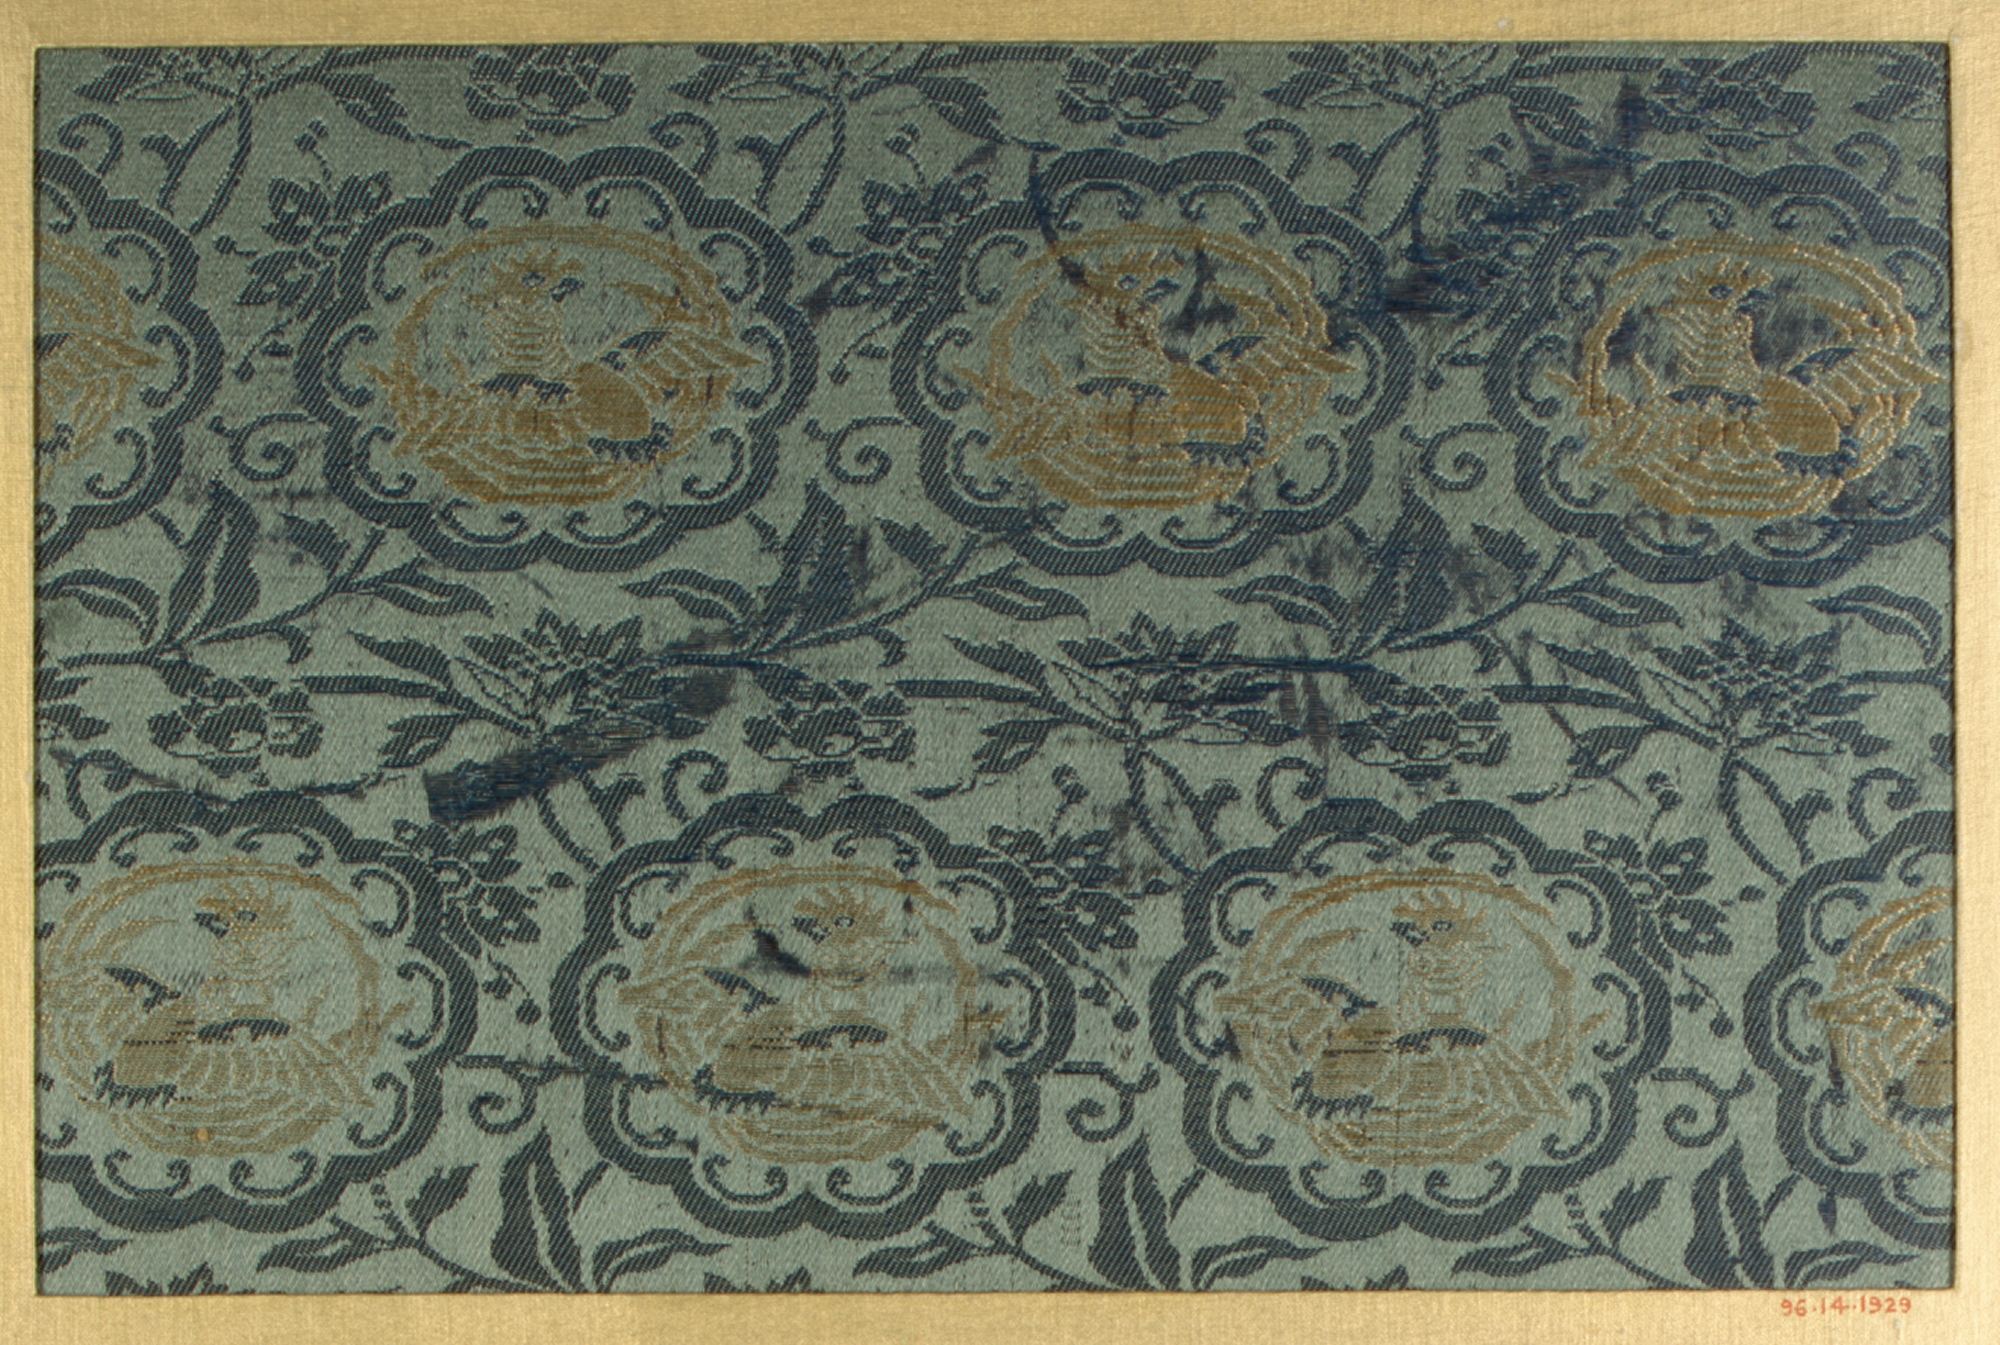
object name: piece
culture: japanese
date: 1701-1900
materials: silk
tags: birds